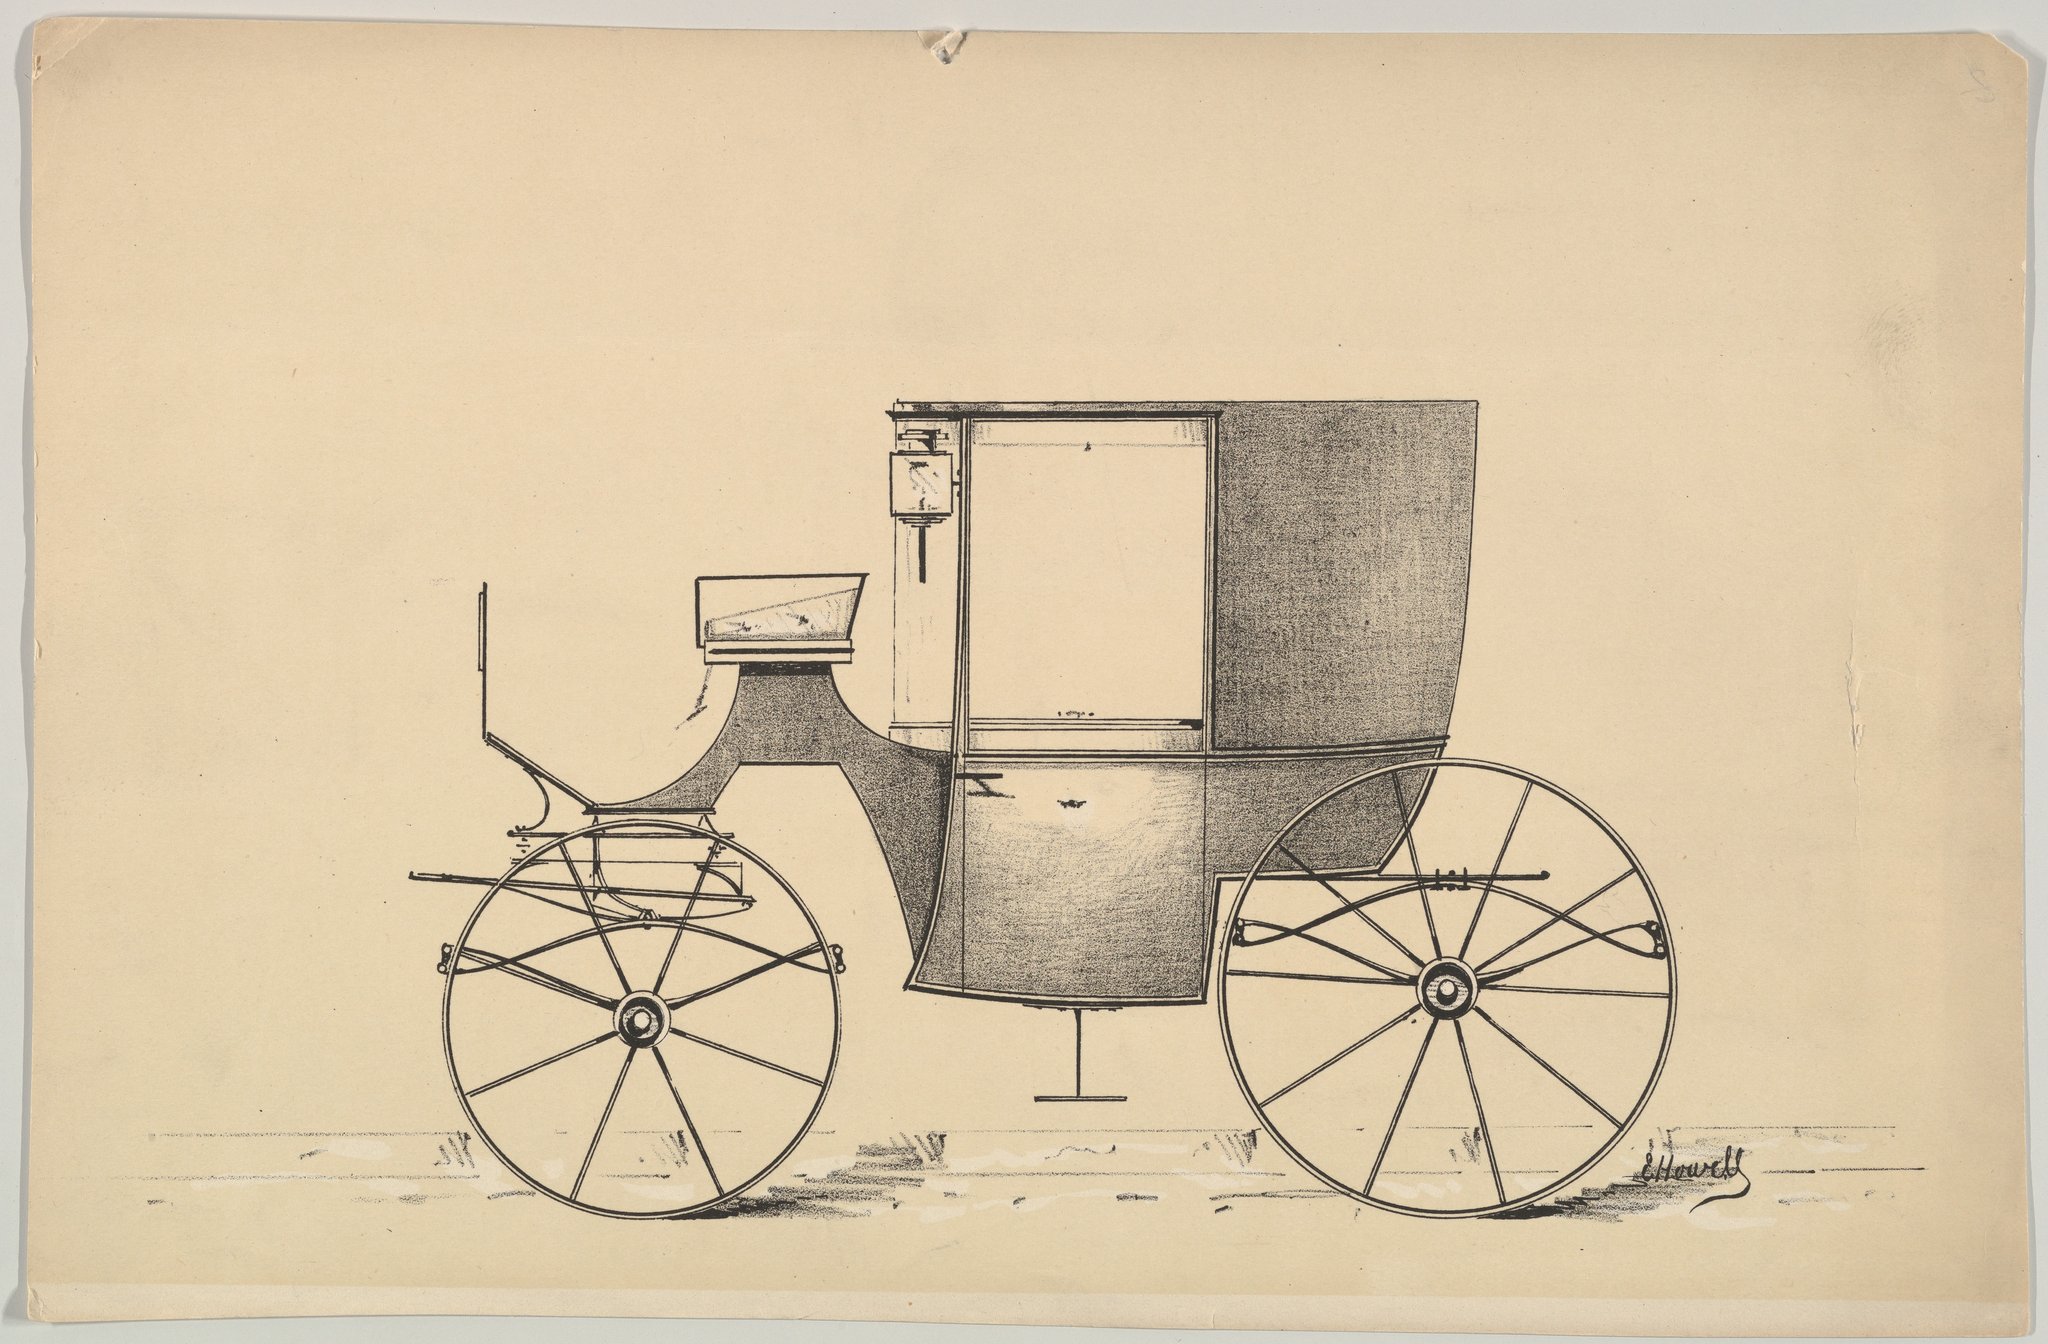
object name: print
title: Coupé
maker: e. howell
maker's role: artist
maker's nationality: american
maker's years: 1850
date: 1850-1870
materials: gouache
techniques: lithograph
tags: carriages